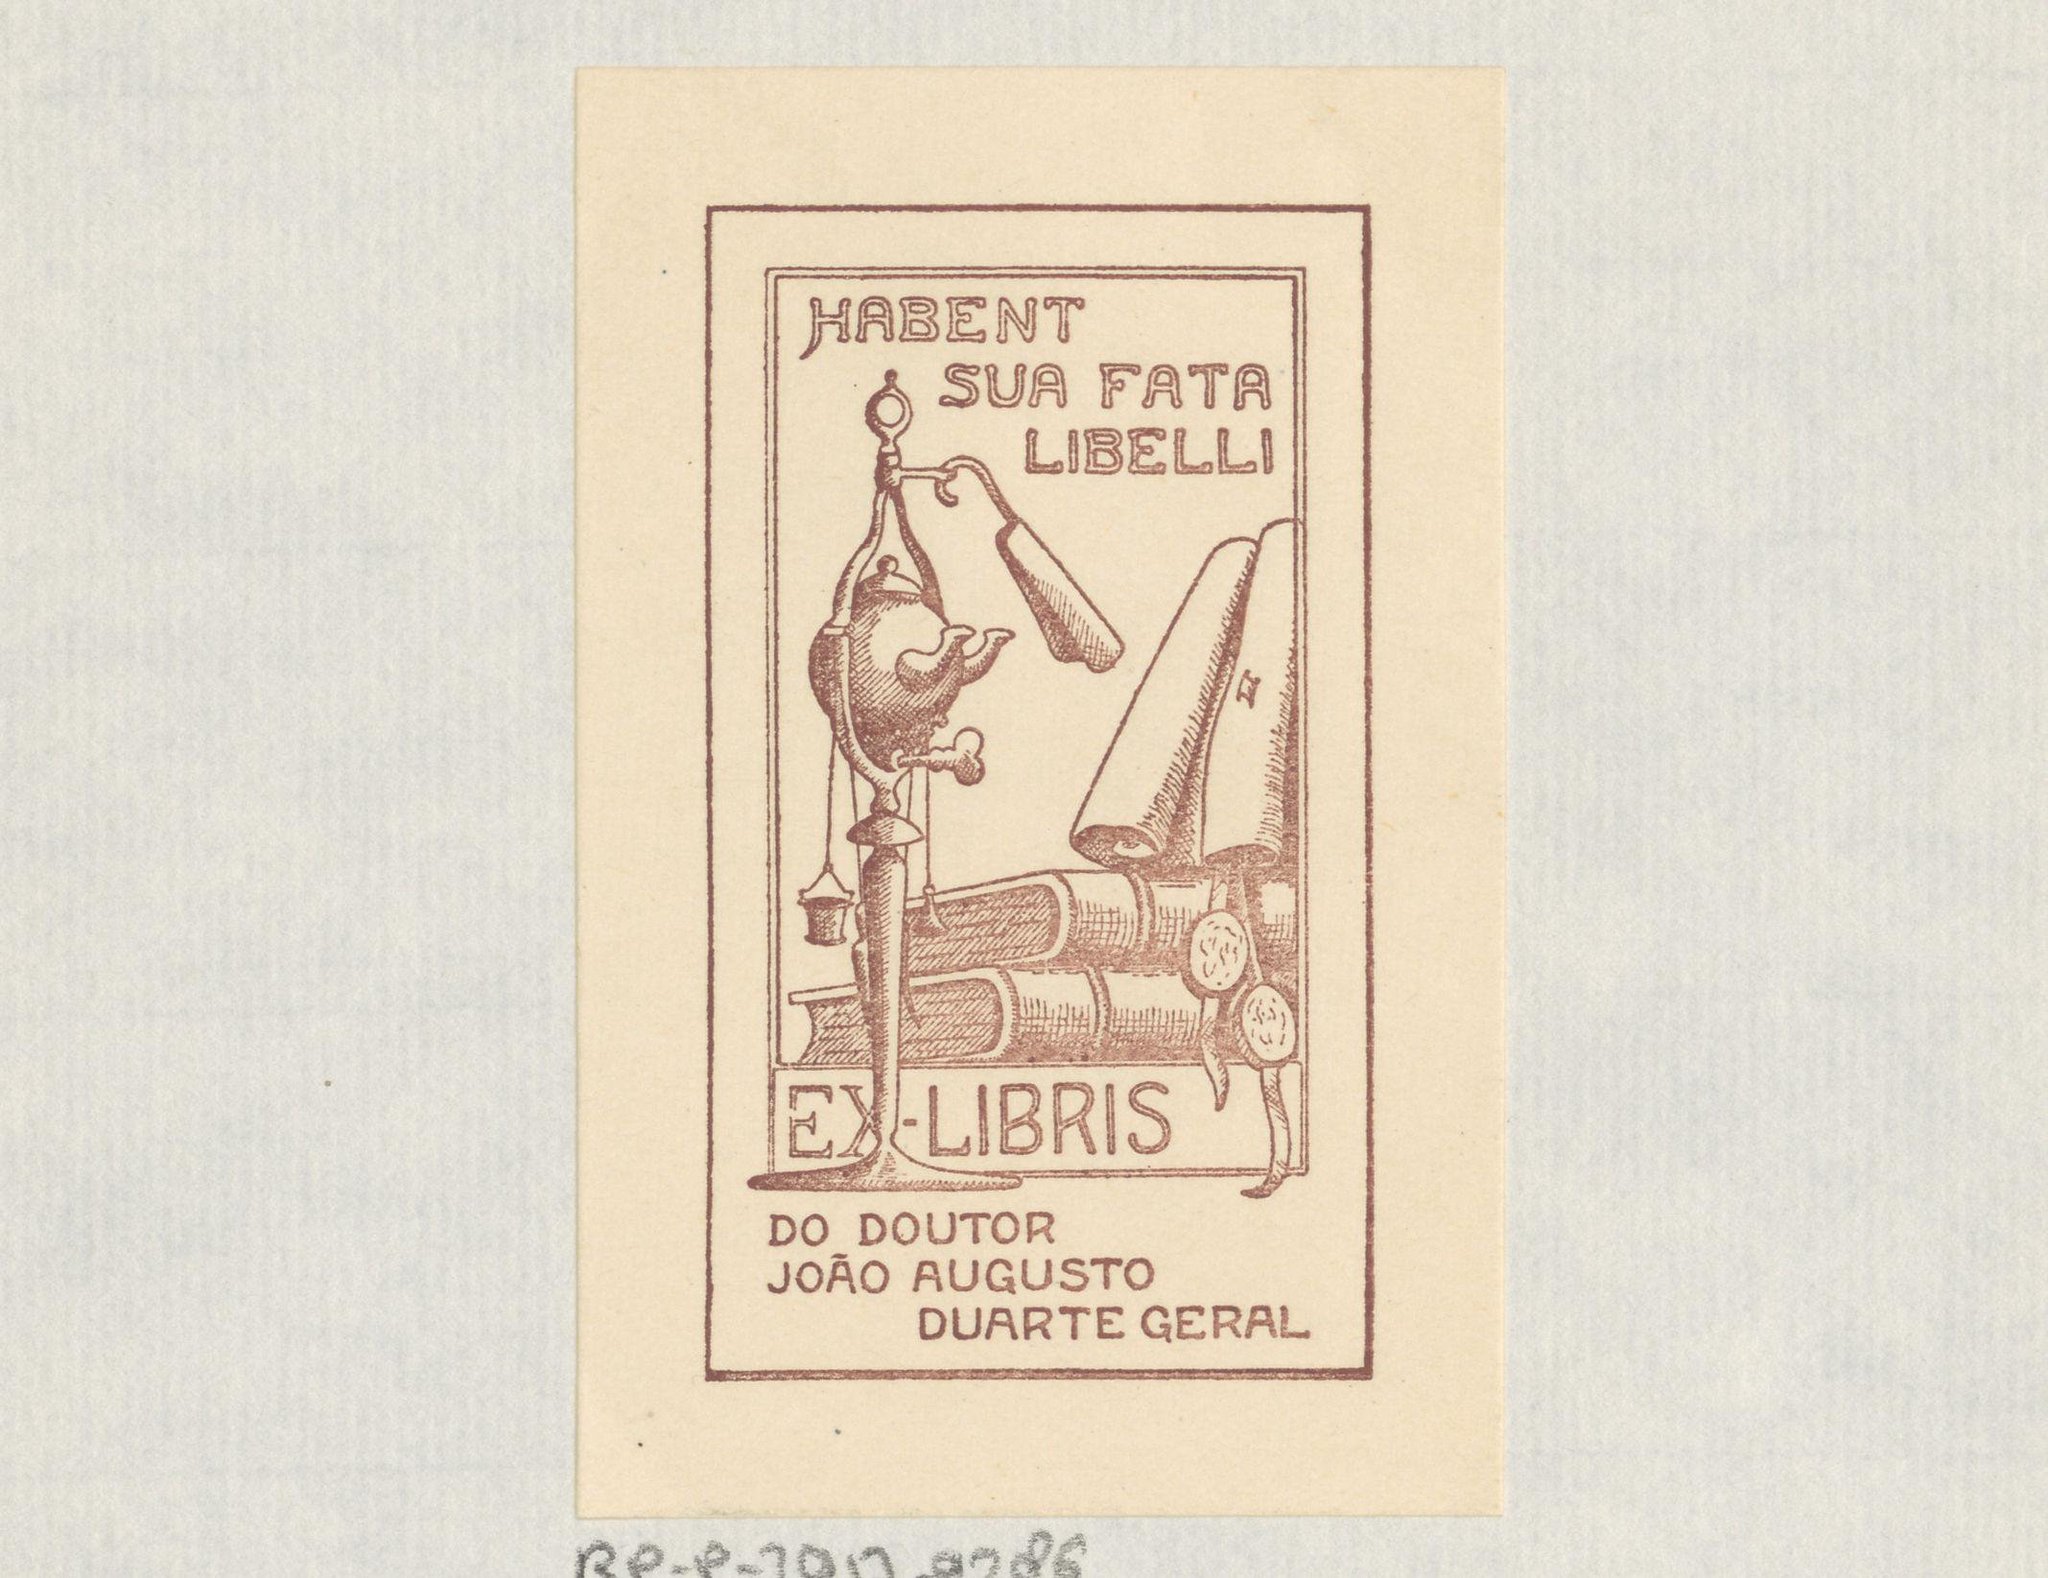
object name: bookplate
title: Habent sua fata libelli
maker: Anonymous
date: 1880-1949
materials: paper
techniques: printing block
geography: spain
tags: book, oil-lamp